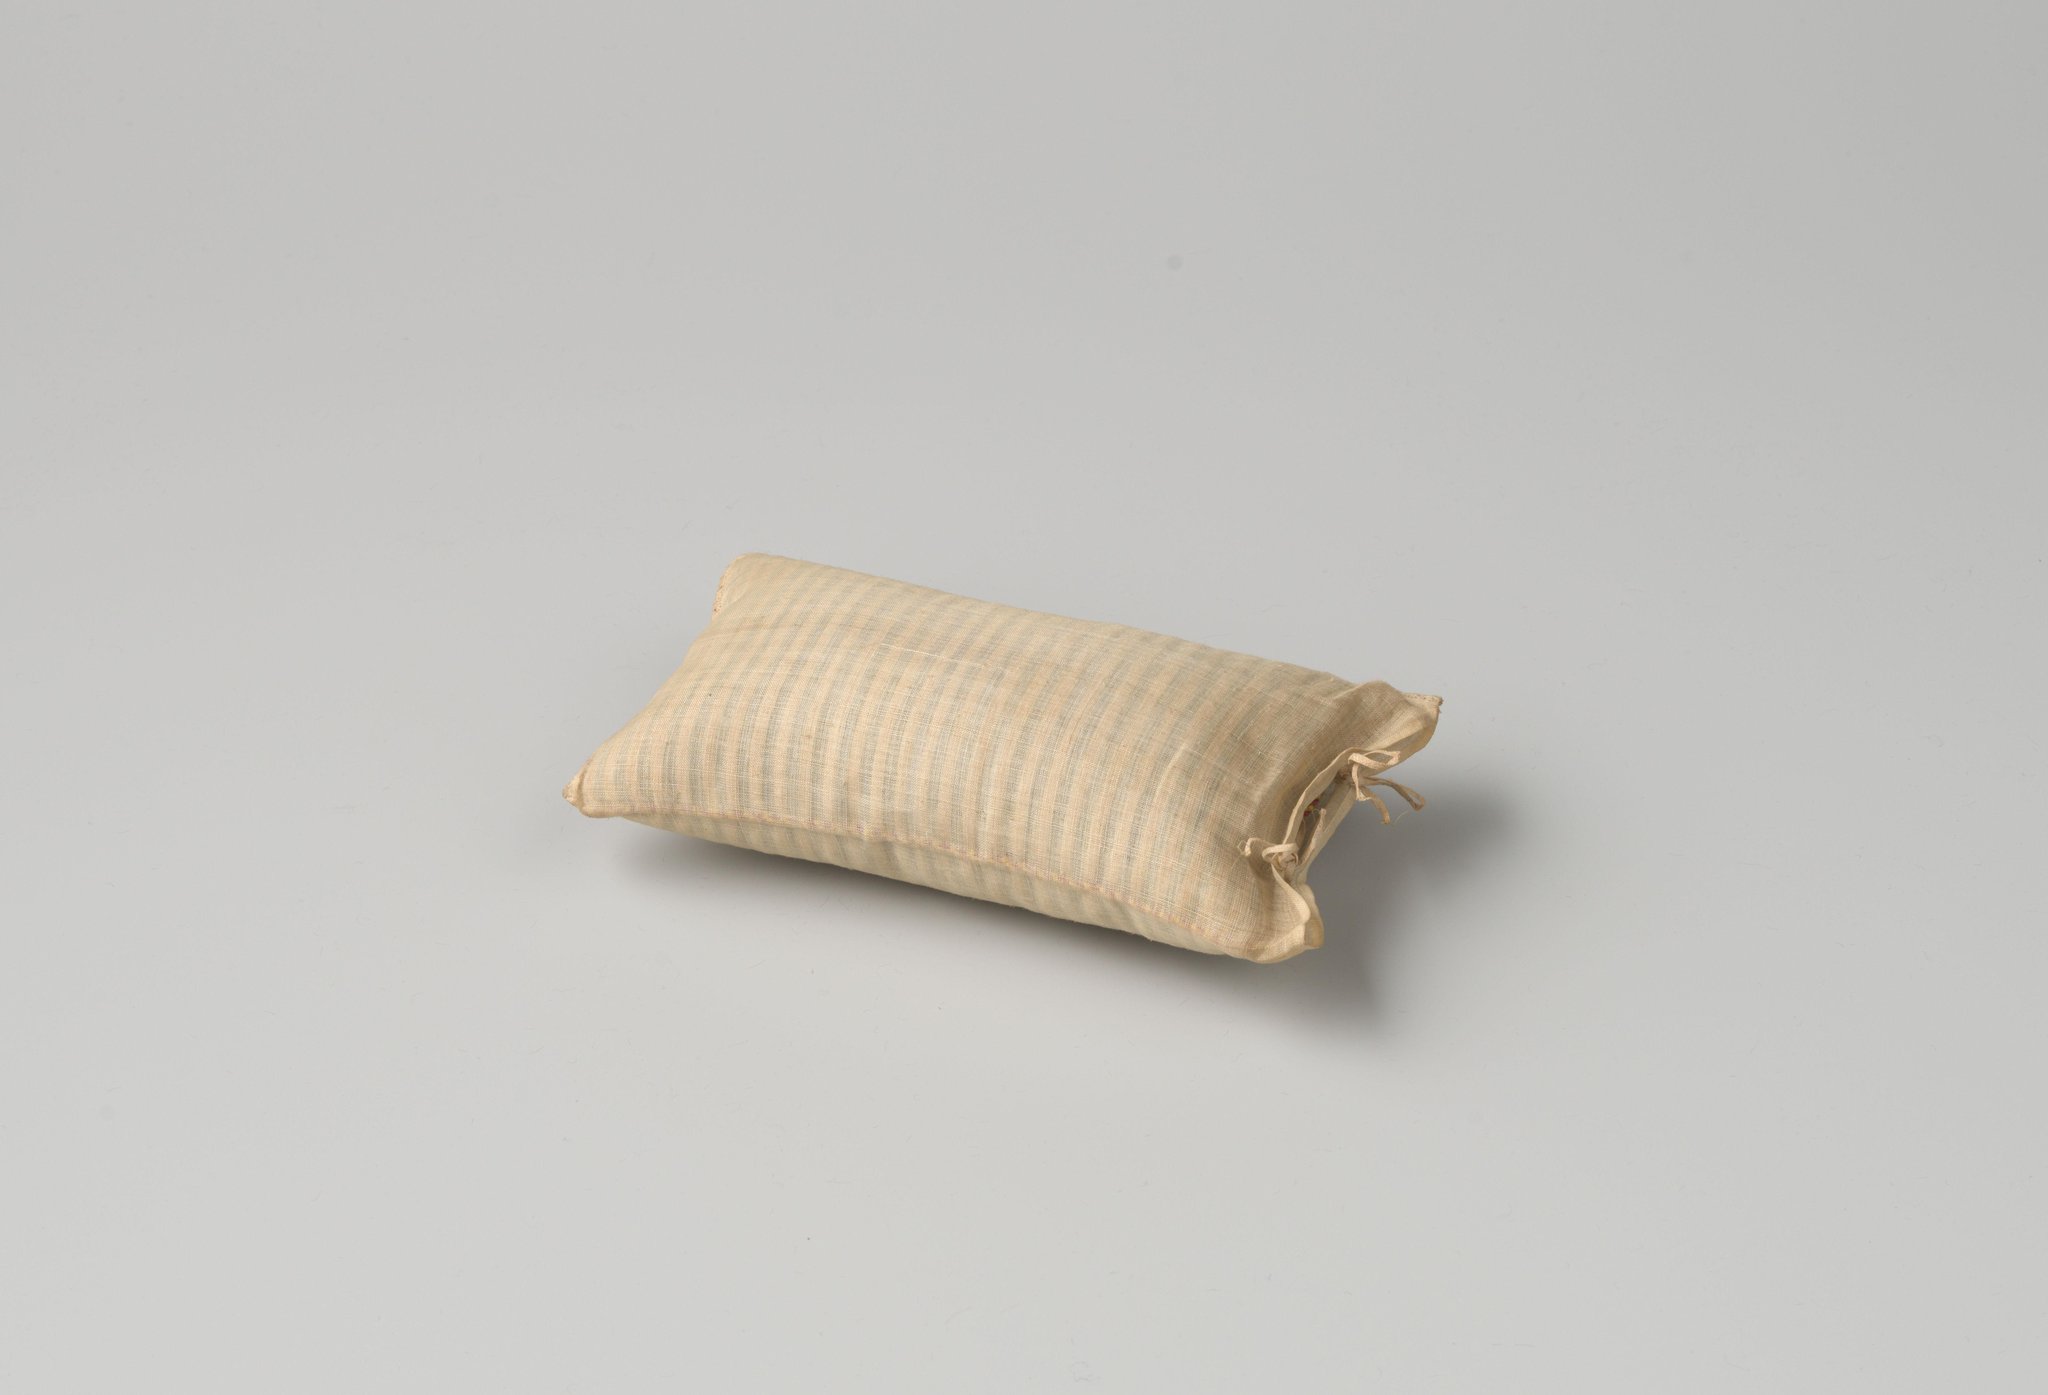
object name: sloop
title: Sloop voor peluwkussen van zeer fijn wit linnen (batist)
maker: Anonymous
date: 1690-1710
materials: linen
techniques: lace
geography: amsterdam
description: Sloop voor peluwkussen van zeer fijn wit linnen (batist), aan twee zijden (lange en korte) met tussenzetsel van kloskant aan zoom; sluiting aan korte zijde d.m.v. 2 x 2 sluitbandjes. 5 mm. van de zoomrand aan binnenzijde vastgezet. Opmerking: Hoort om peluw van kraambed.